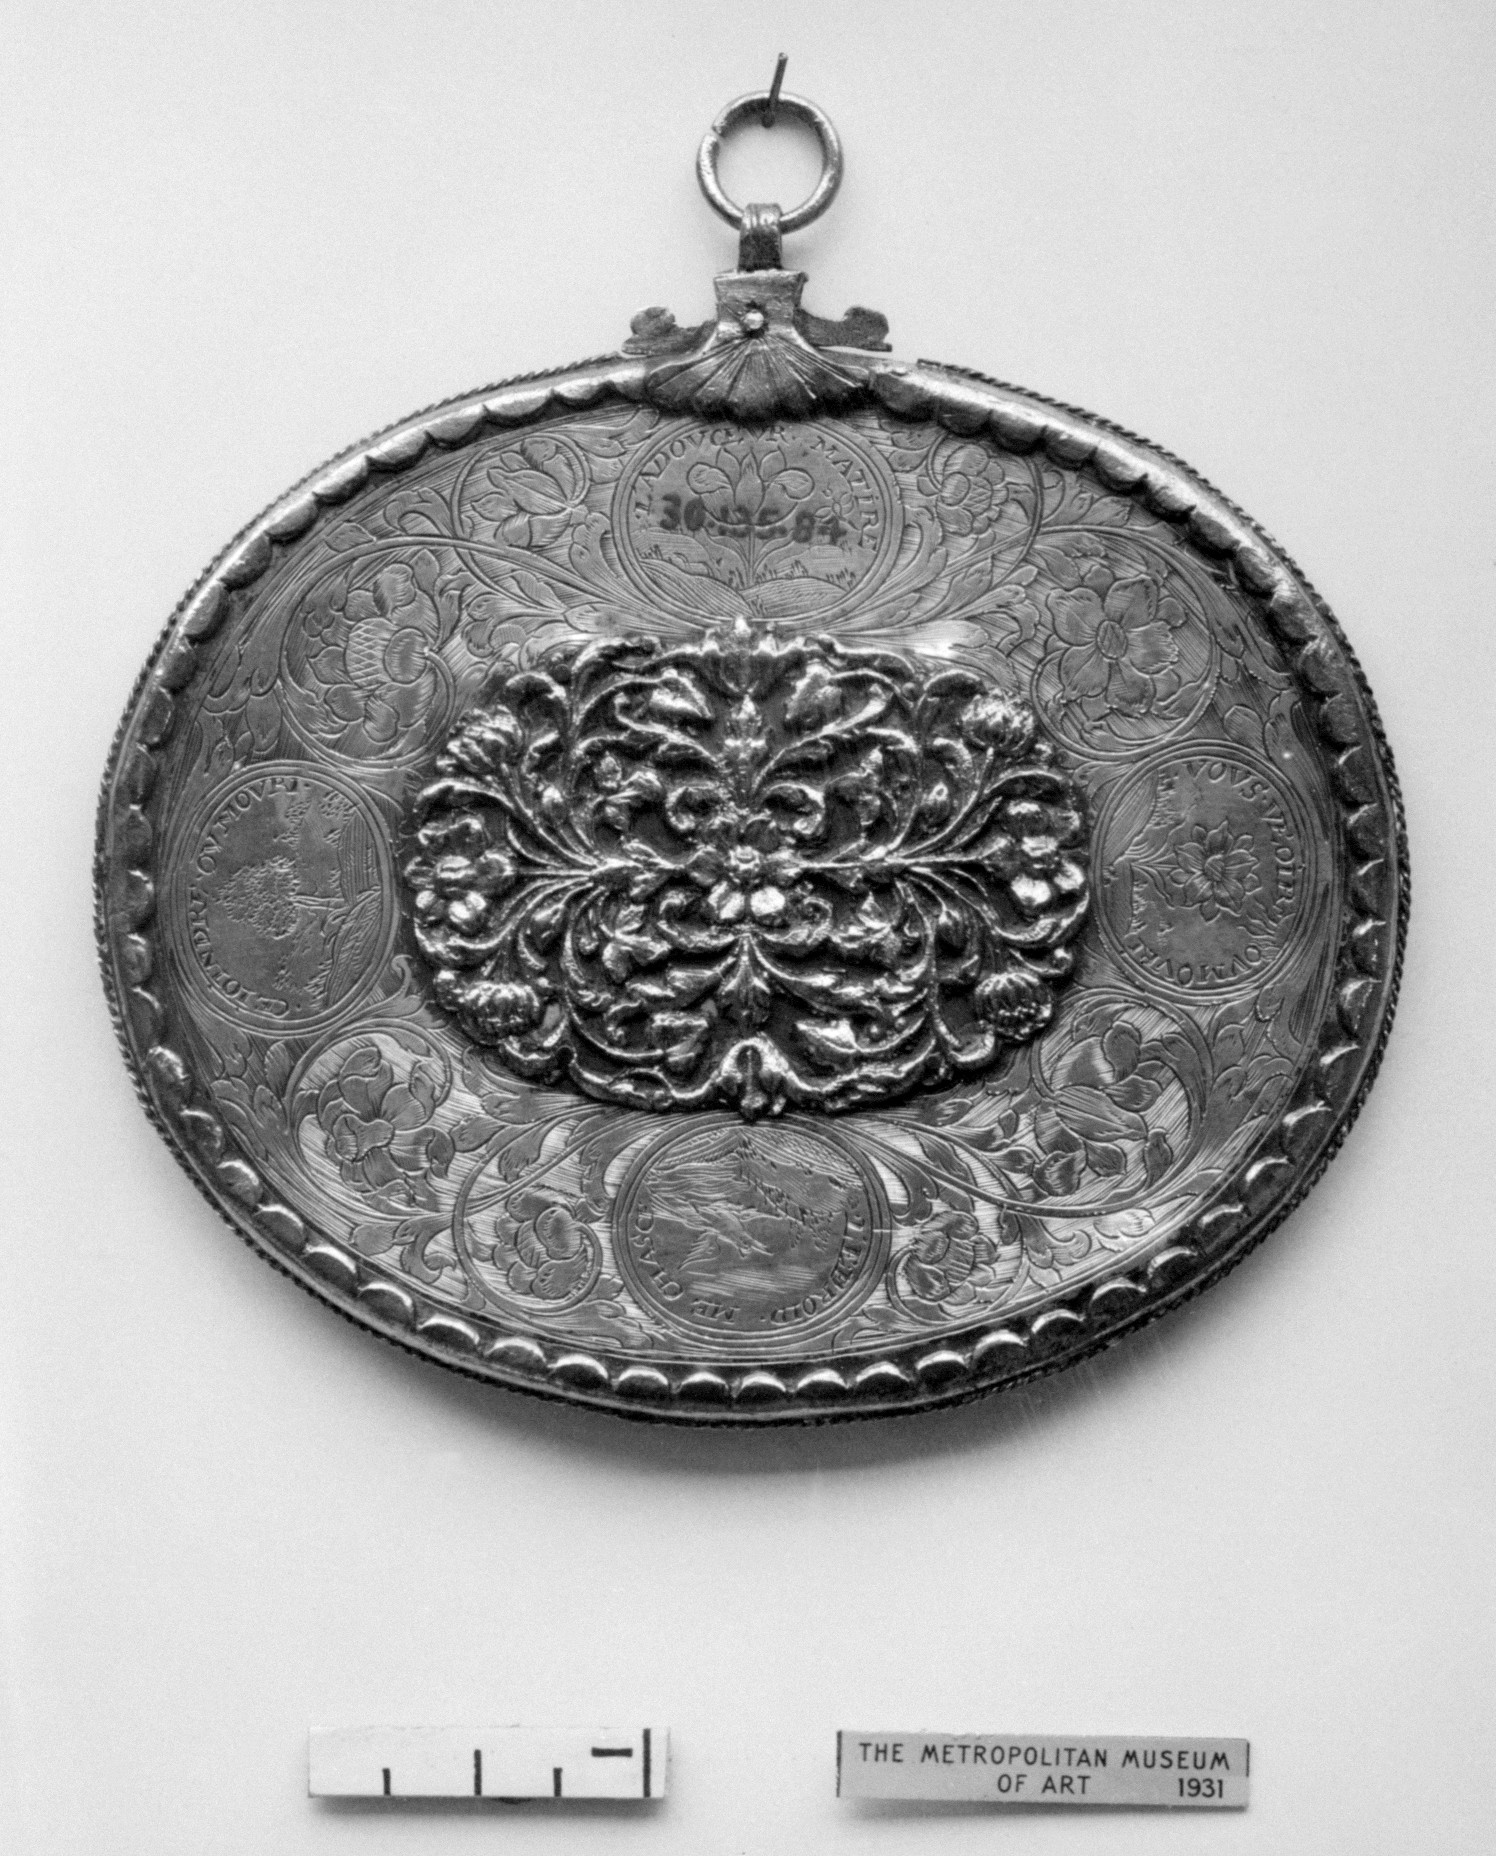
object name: mirror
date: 1601-1700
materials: gilt, silver